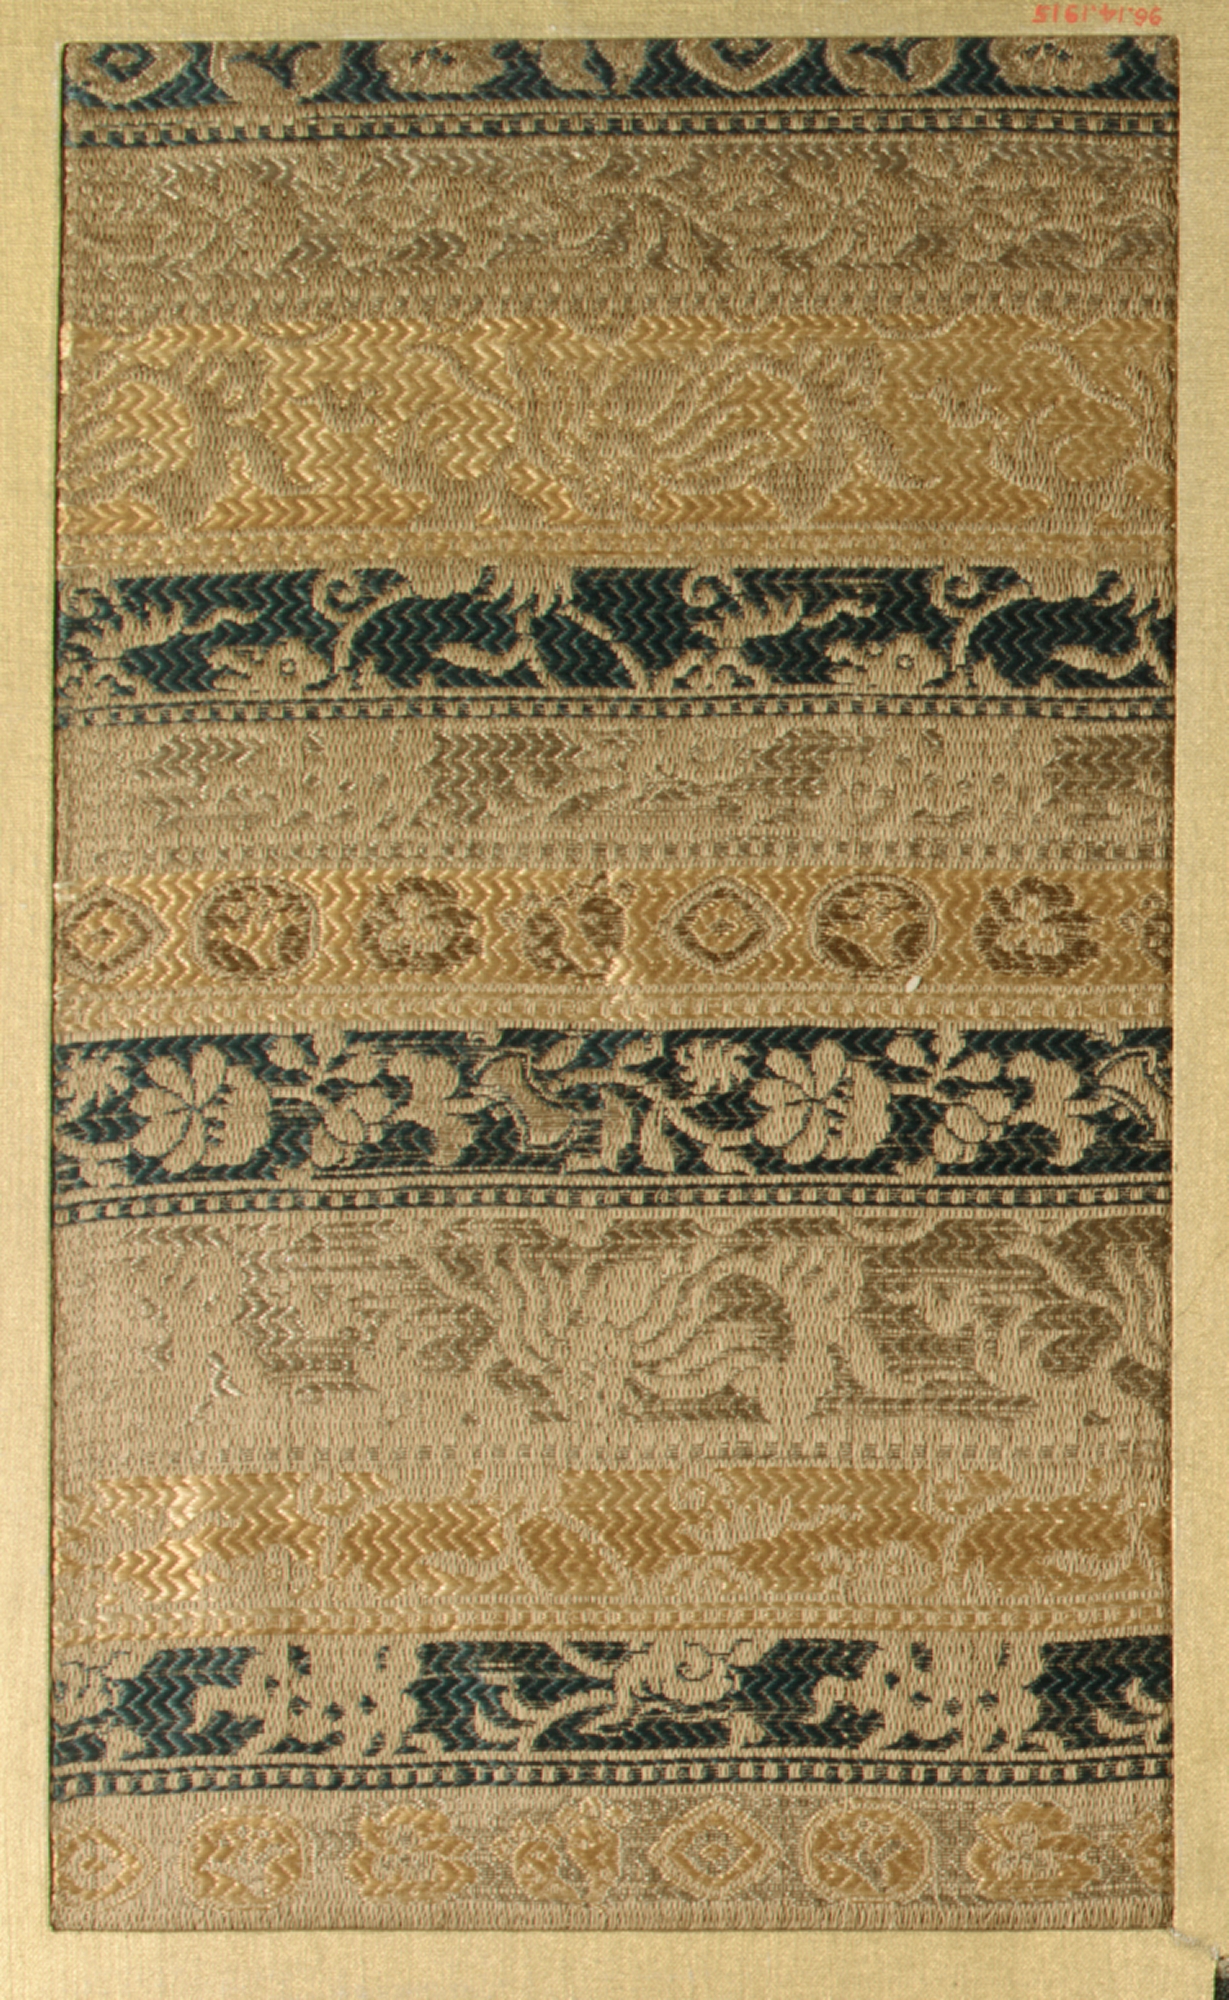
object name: piece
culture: japanese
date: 1701-1900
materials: silk